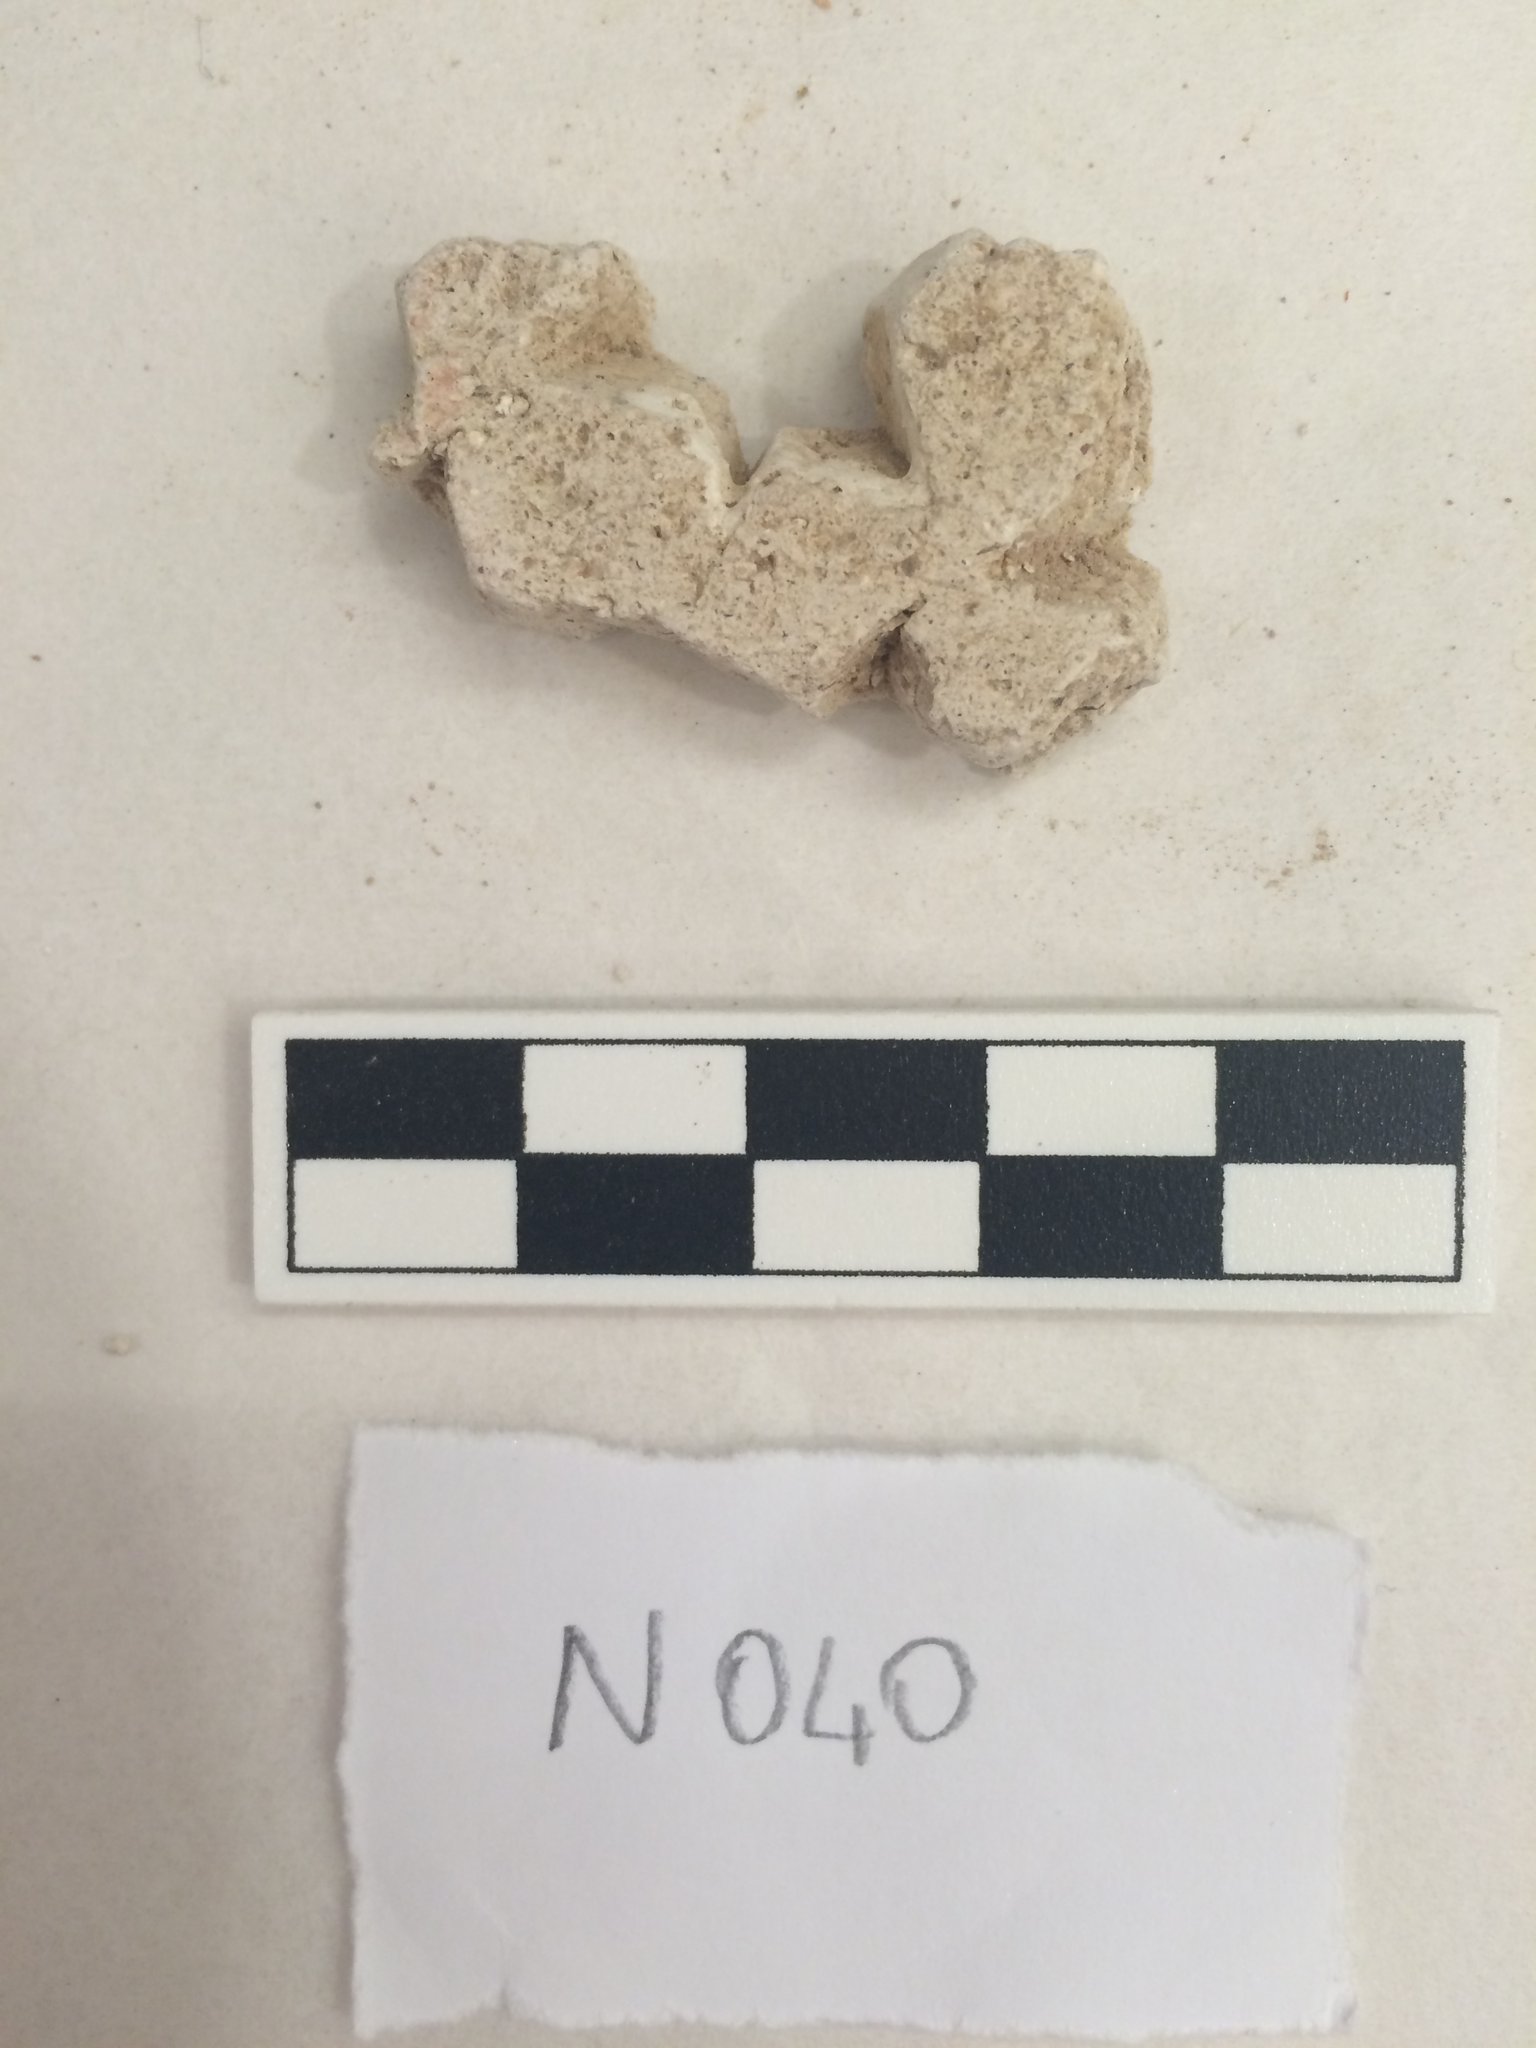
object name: fragment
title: Stucco Fragment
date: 701-1200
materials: plaster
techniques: carving, painting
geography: iran